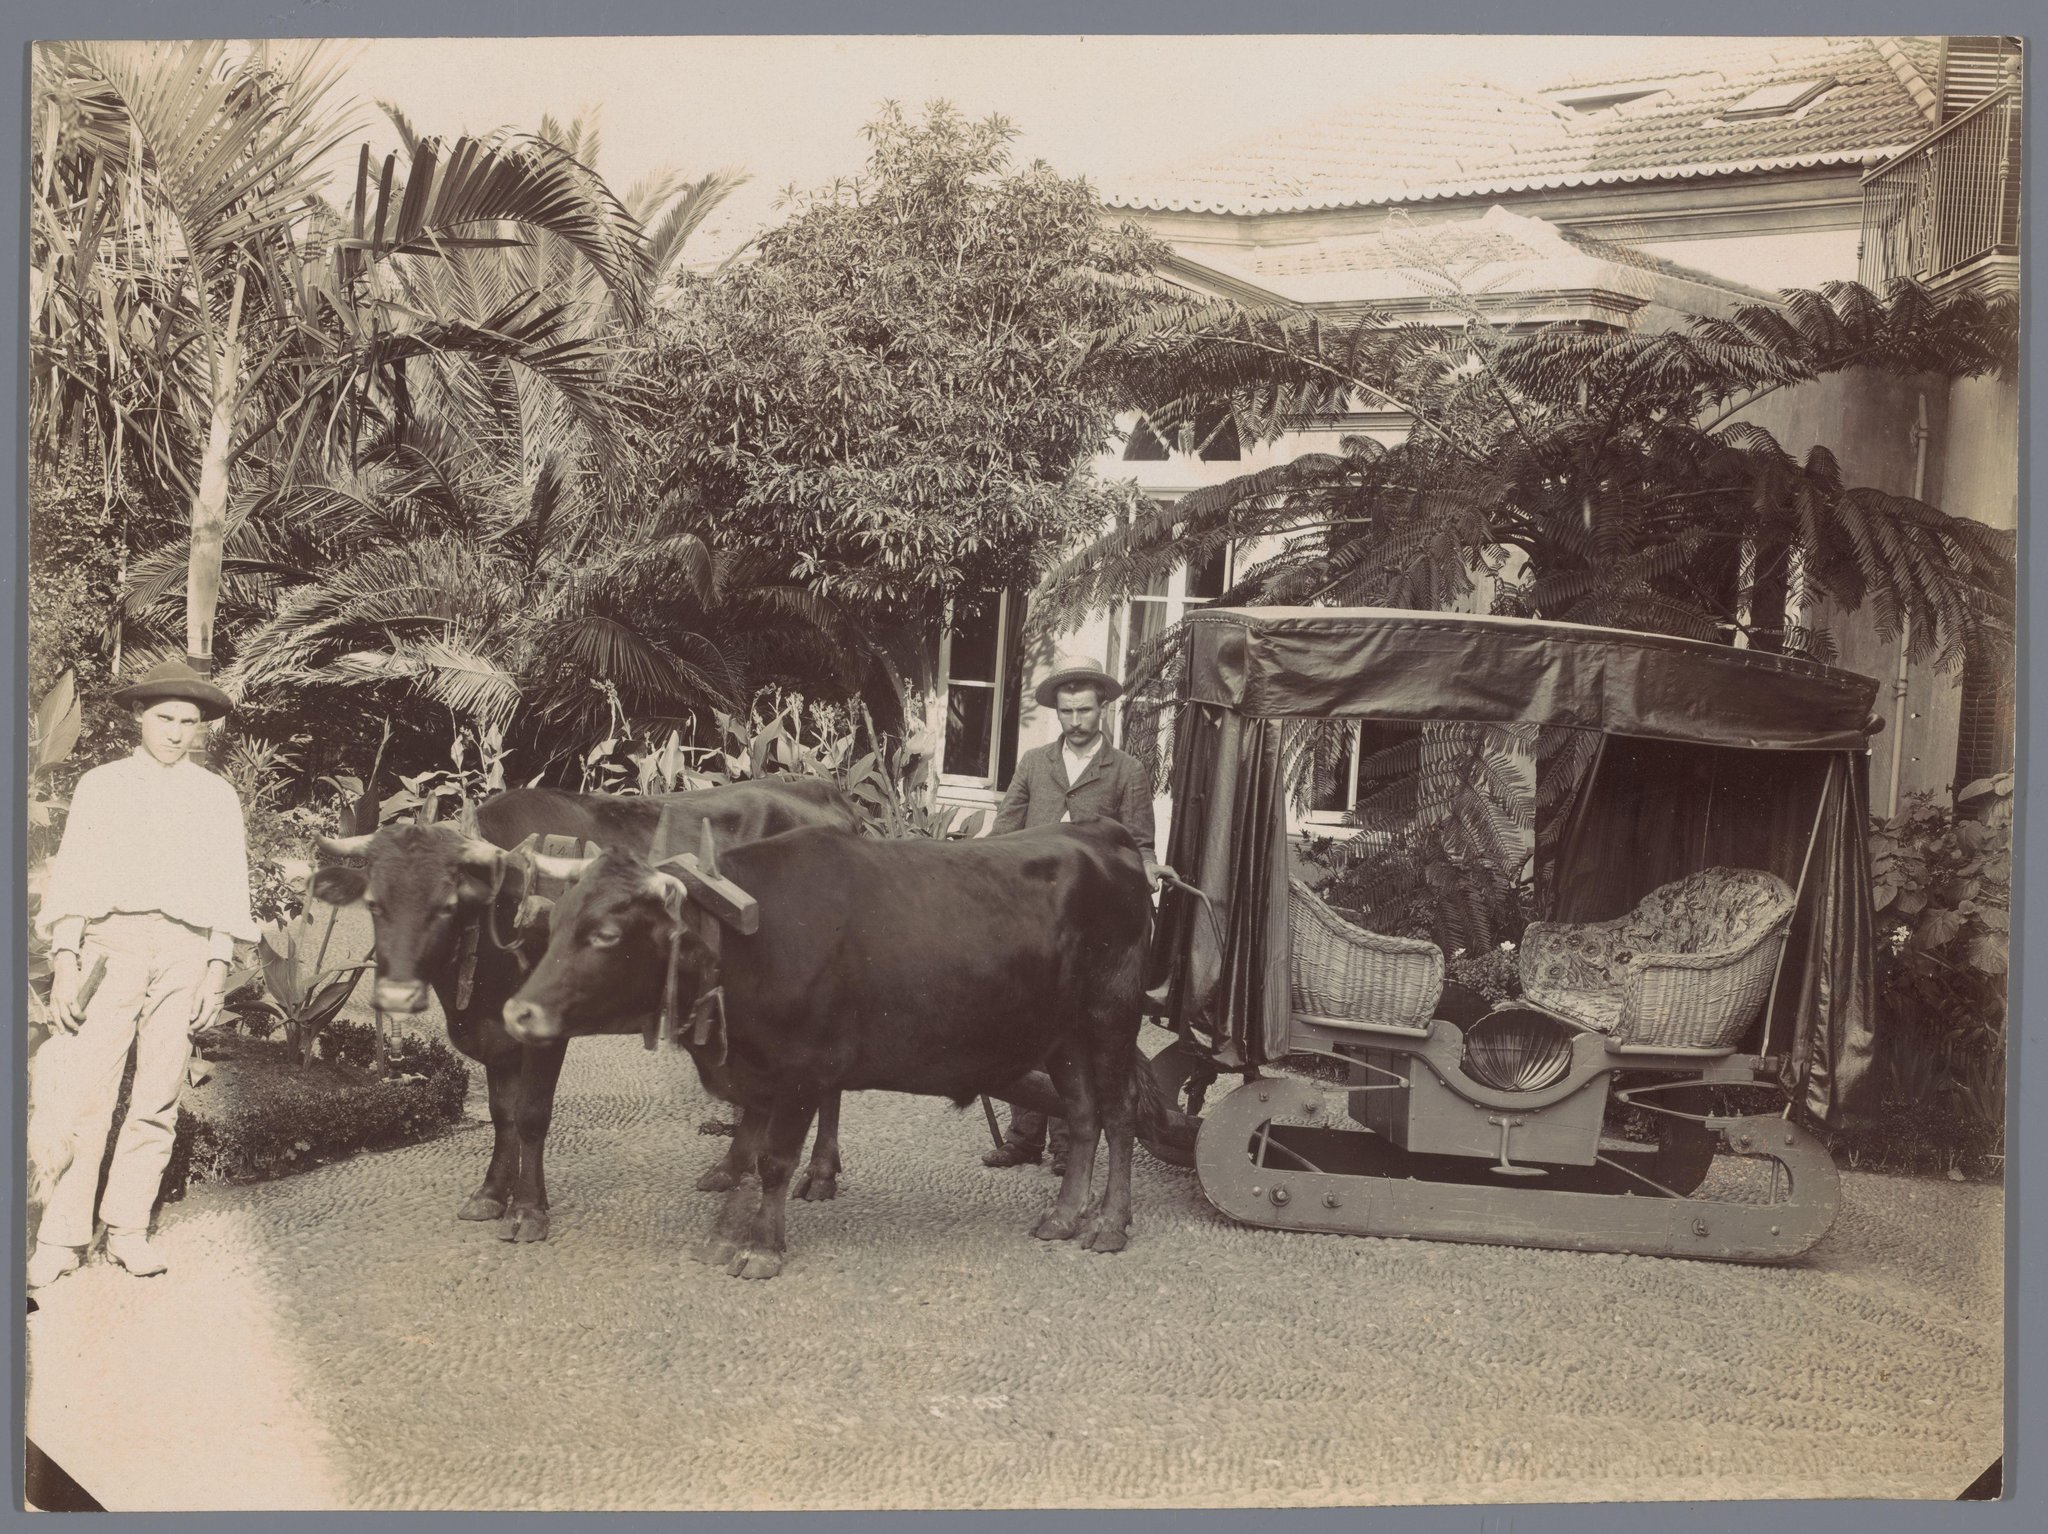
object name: photograph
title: Rijtuig op ijzers voortgetrokken door ossen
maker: manuel de olim perestrello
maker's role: fotograaf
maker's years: 1854-1929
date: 1880-1920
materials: paper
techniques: collodion silver print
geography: madeira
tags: animal traction, animal-drawn vehicle (carriage etc.), animal-drawn sledge (dutch: 'toeslede')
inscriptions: inscription: ‘Madeira/ Bullock Carro’